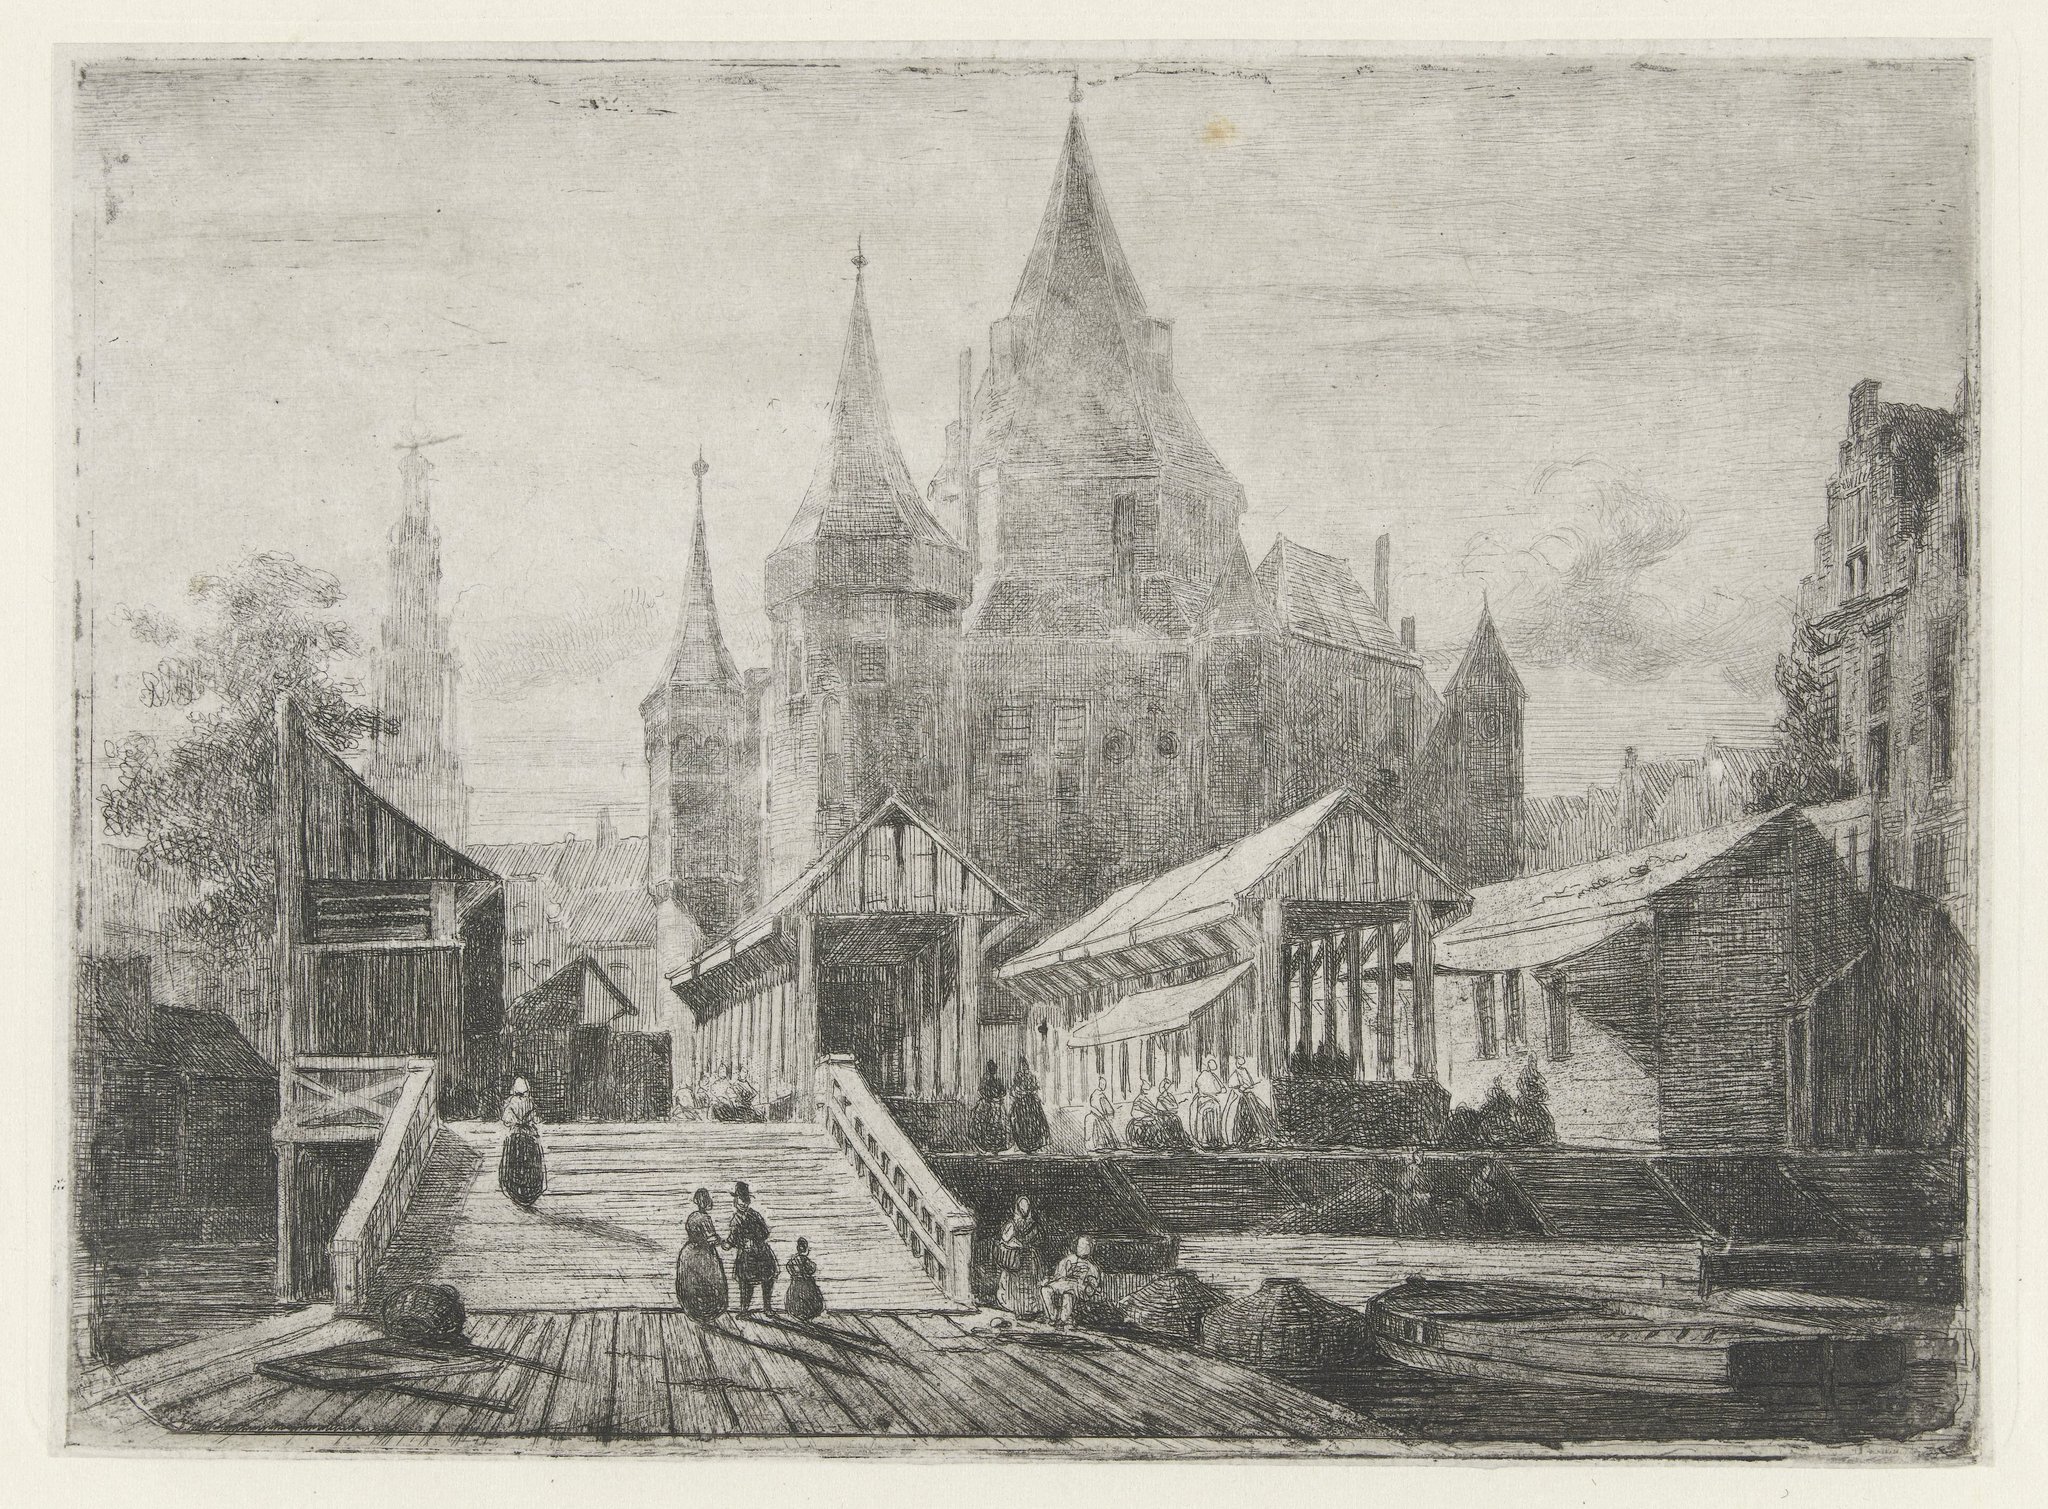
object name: print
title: Gezicht op de Nieuwmarkt te Amsterdam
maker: lambertus hardenberg (1822-1900)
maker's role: draughtsman, painter, print maker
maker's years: 1822-1900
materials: paper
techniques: etching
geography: the hague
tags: market, bridge, weigh-house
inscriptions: collector's mark: Lugt 2760, collector's mark: Lugt 2228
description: Gezicht op de Nieuwmarkt in Amsterdam, met op de voorgrond figuren bij een houten brug en markthallen, op de achtergrond de Waag of de St. Anthonispoort en de toren van de Zuiderkerk.